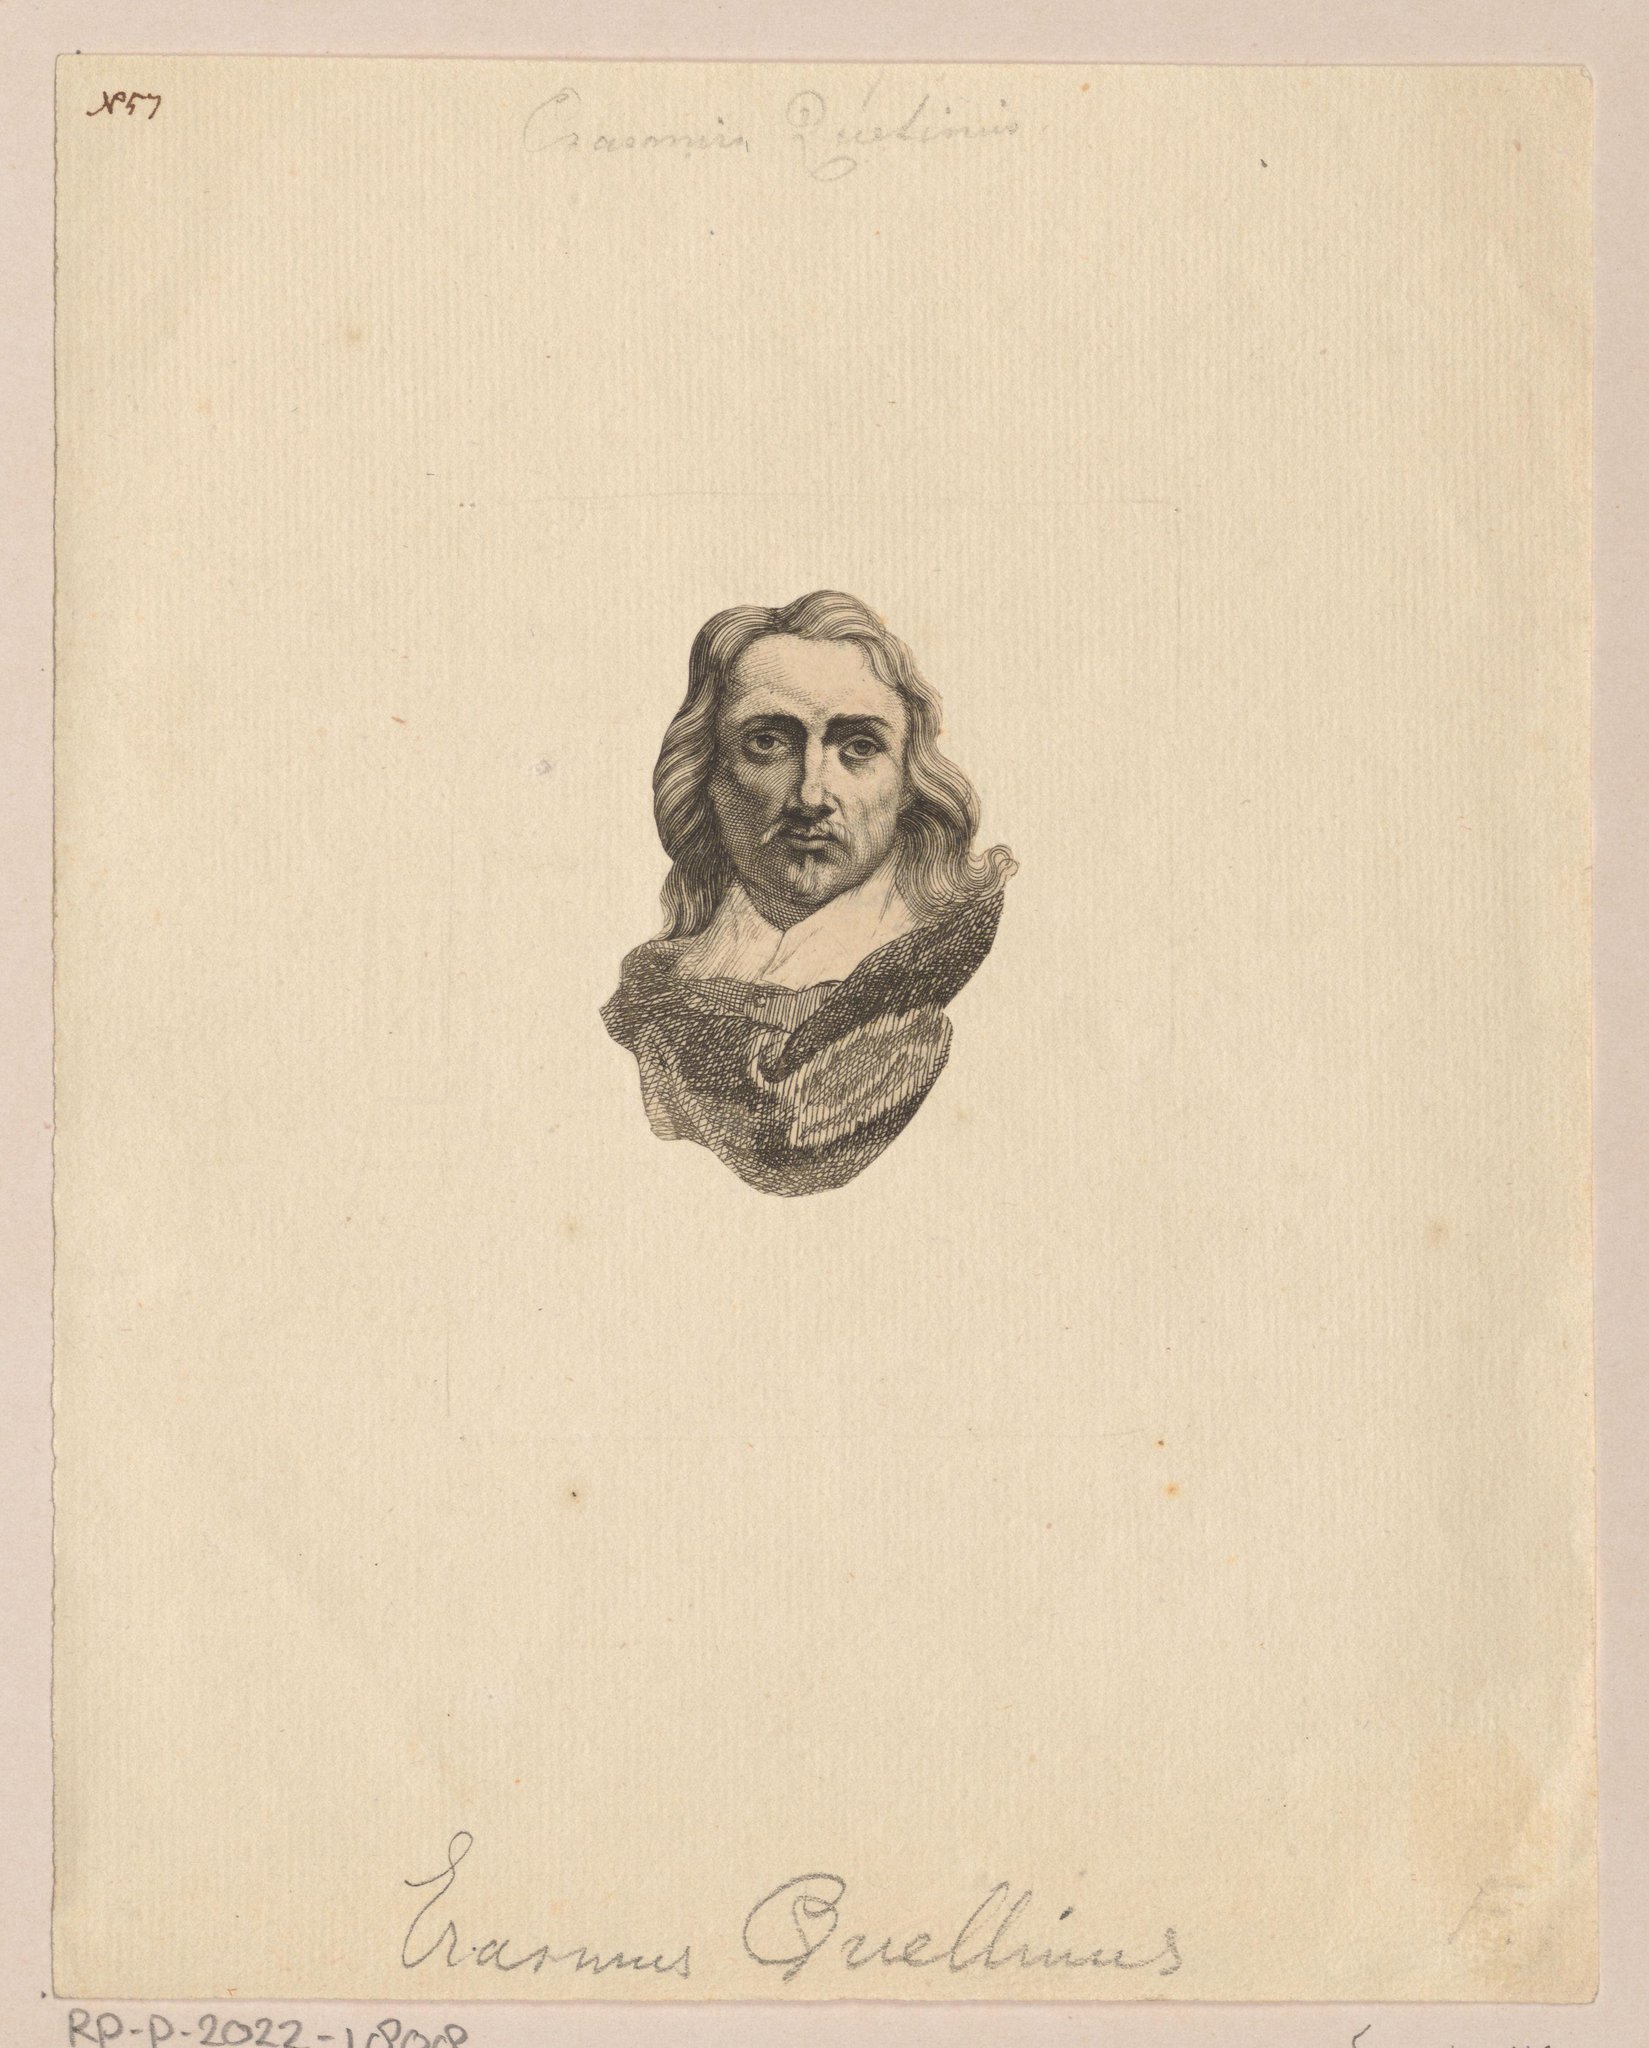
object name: print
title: Portret van Erasmus Quellinus II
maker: jacob houbraken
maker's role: draughtsman, print maker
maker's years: 1698-1780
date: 1718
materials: paper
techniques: engraving, etching, snipping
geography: amsterdam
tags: erasmus quellinus (ii), historical persons, portrait, self-portrait of artist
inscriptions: collector's mark: Lugt 964, number: ‘No 57’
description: Volledige prent gebruikt in: Houbraken, Arnold. De groote Schouburgh der Nederlantsche konstschilders en schilderessen (...). 3 dln. Tweede druk. Amsterdam: s.n., 1718, dl. 1. Prent ook gebruikt in de latere publicatie van 1753.